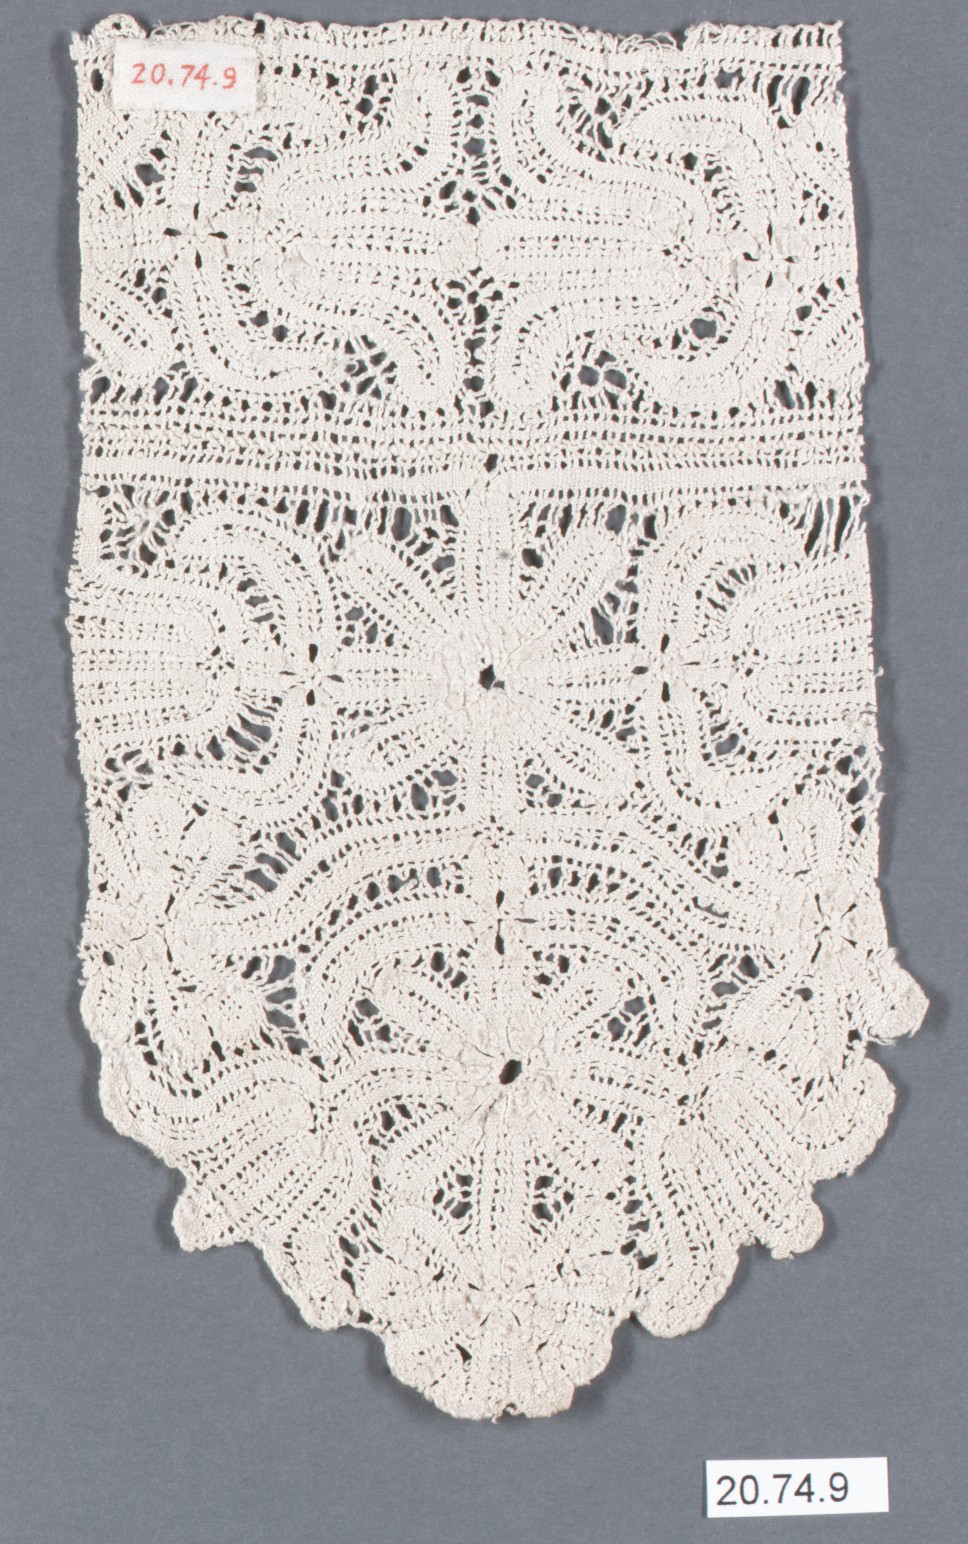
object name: piece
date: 1701-1800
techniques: lace